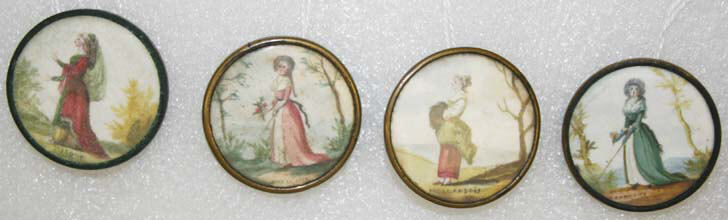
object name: button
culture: european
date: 1775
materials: glass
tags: women